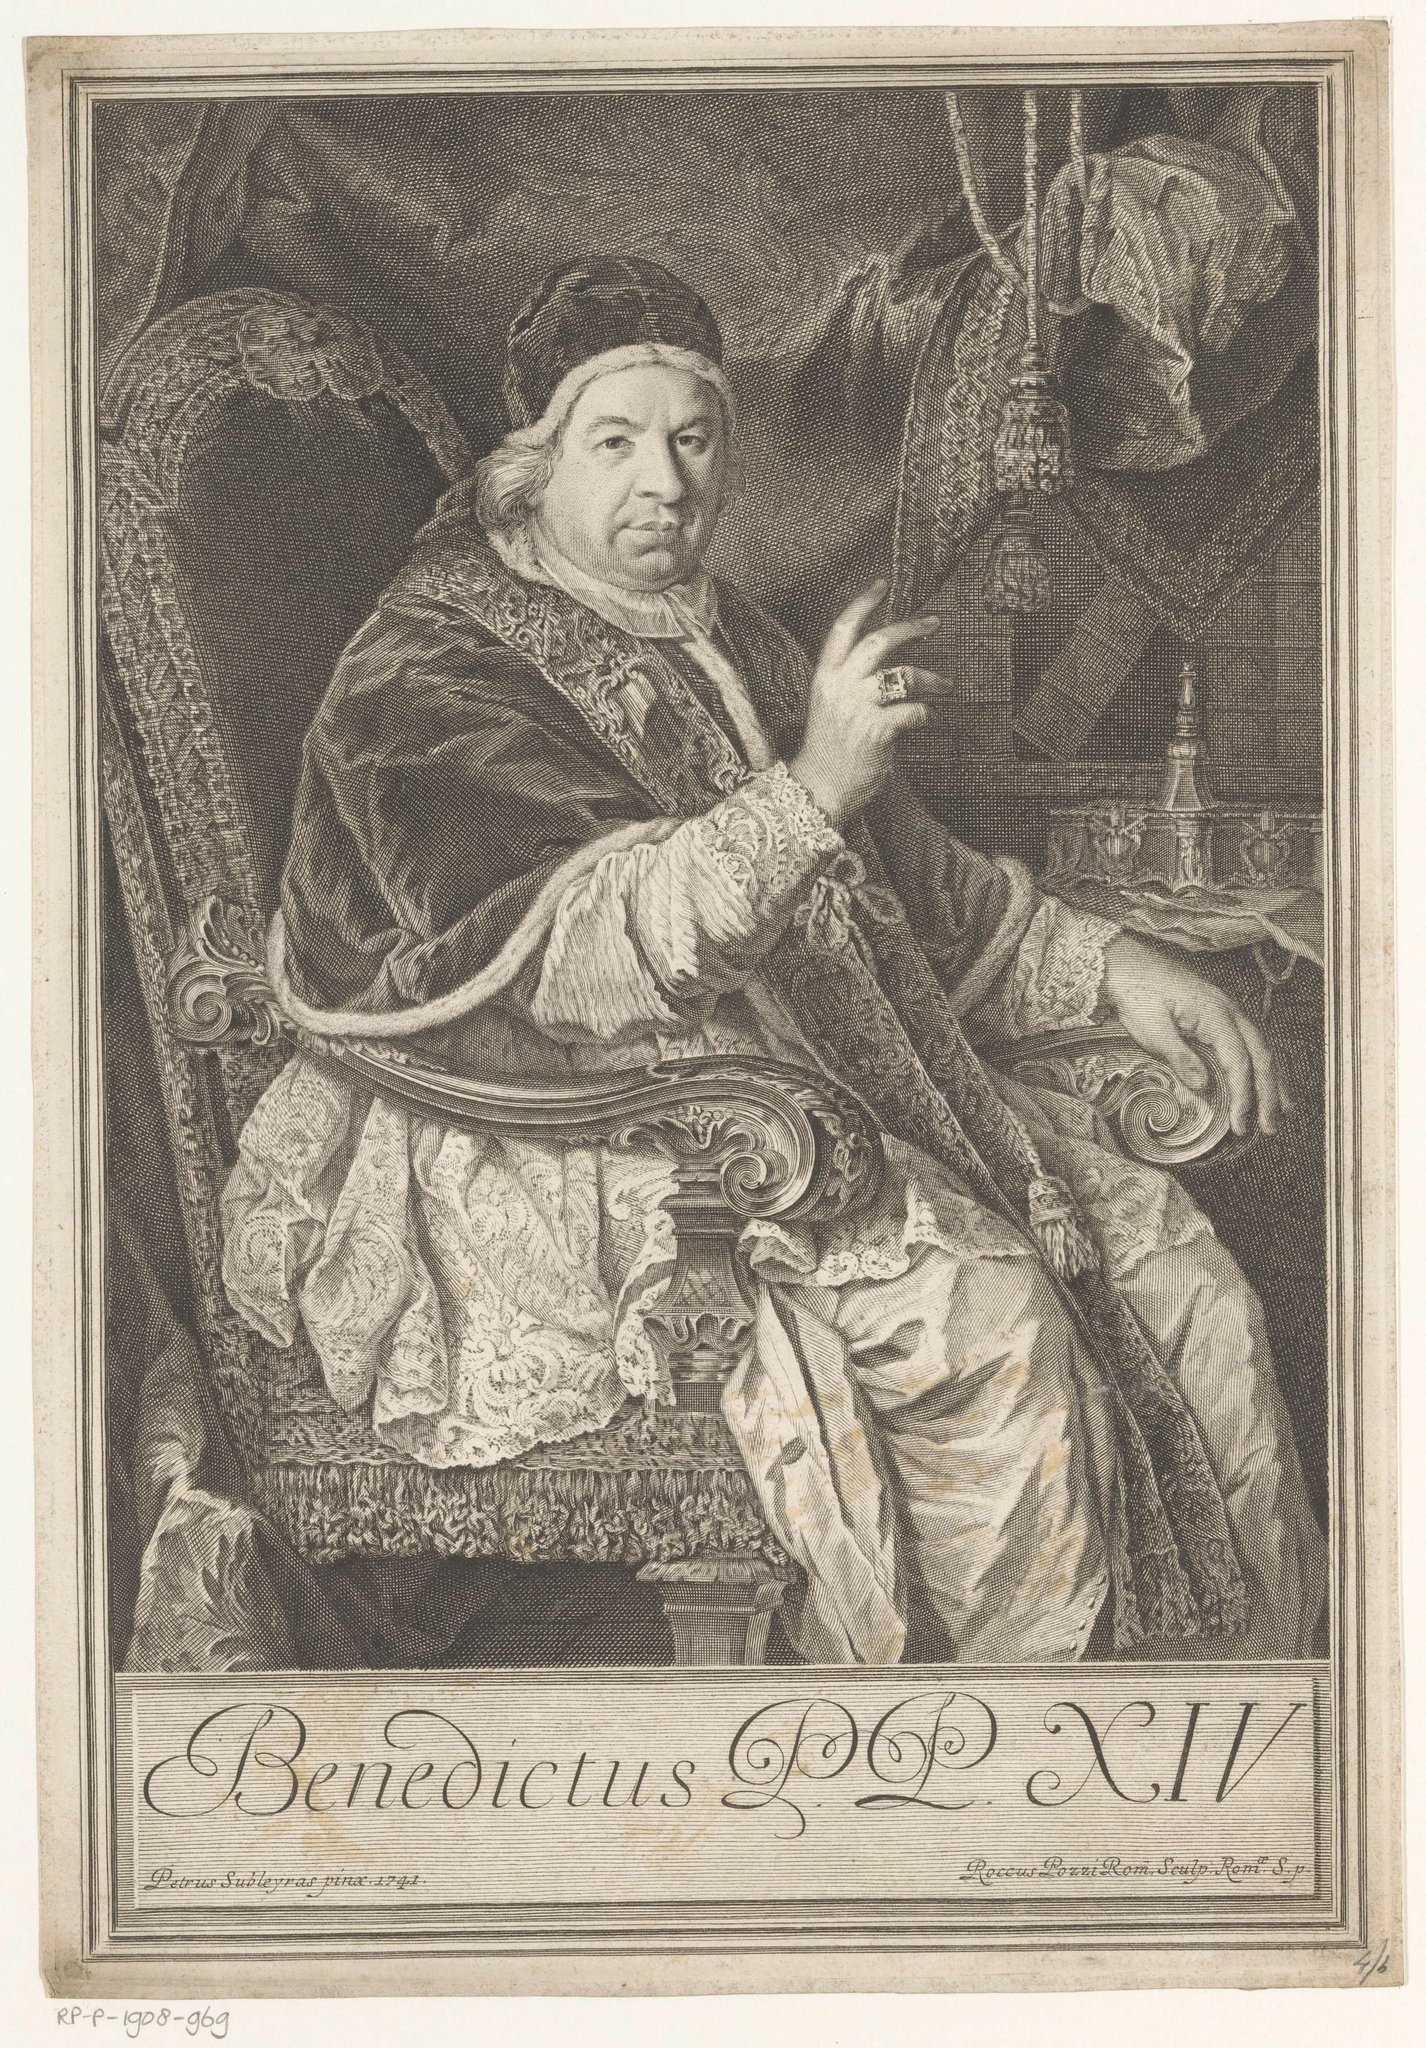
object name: print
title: Portret van paus Benedictus XIV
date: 1741-1780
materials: paper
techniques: engraving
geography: vatican city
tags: rome, benedictus xiv, historical persons, pope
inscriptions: collector's mark: Lugt 2228